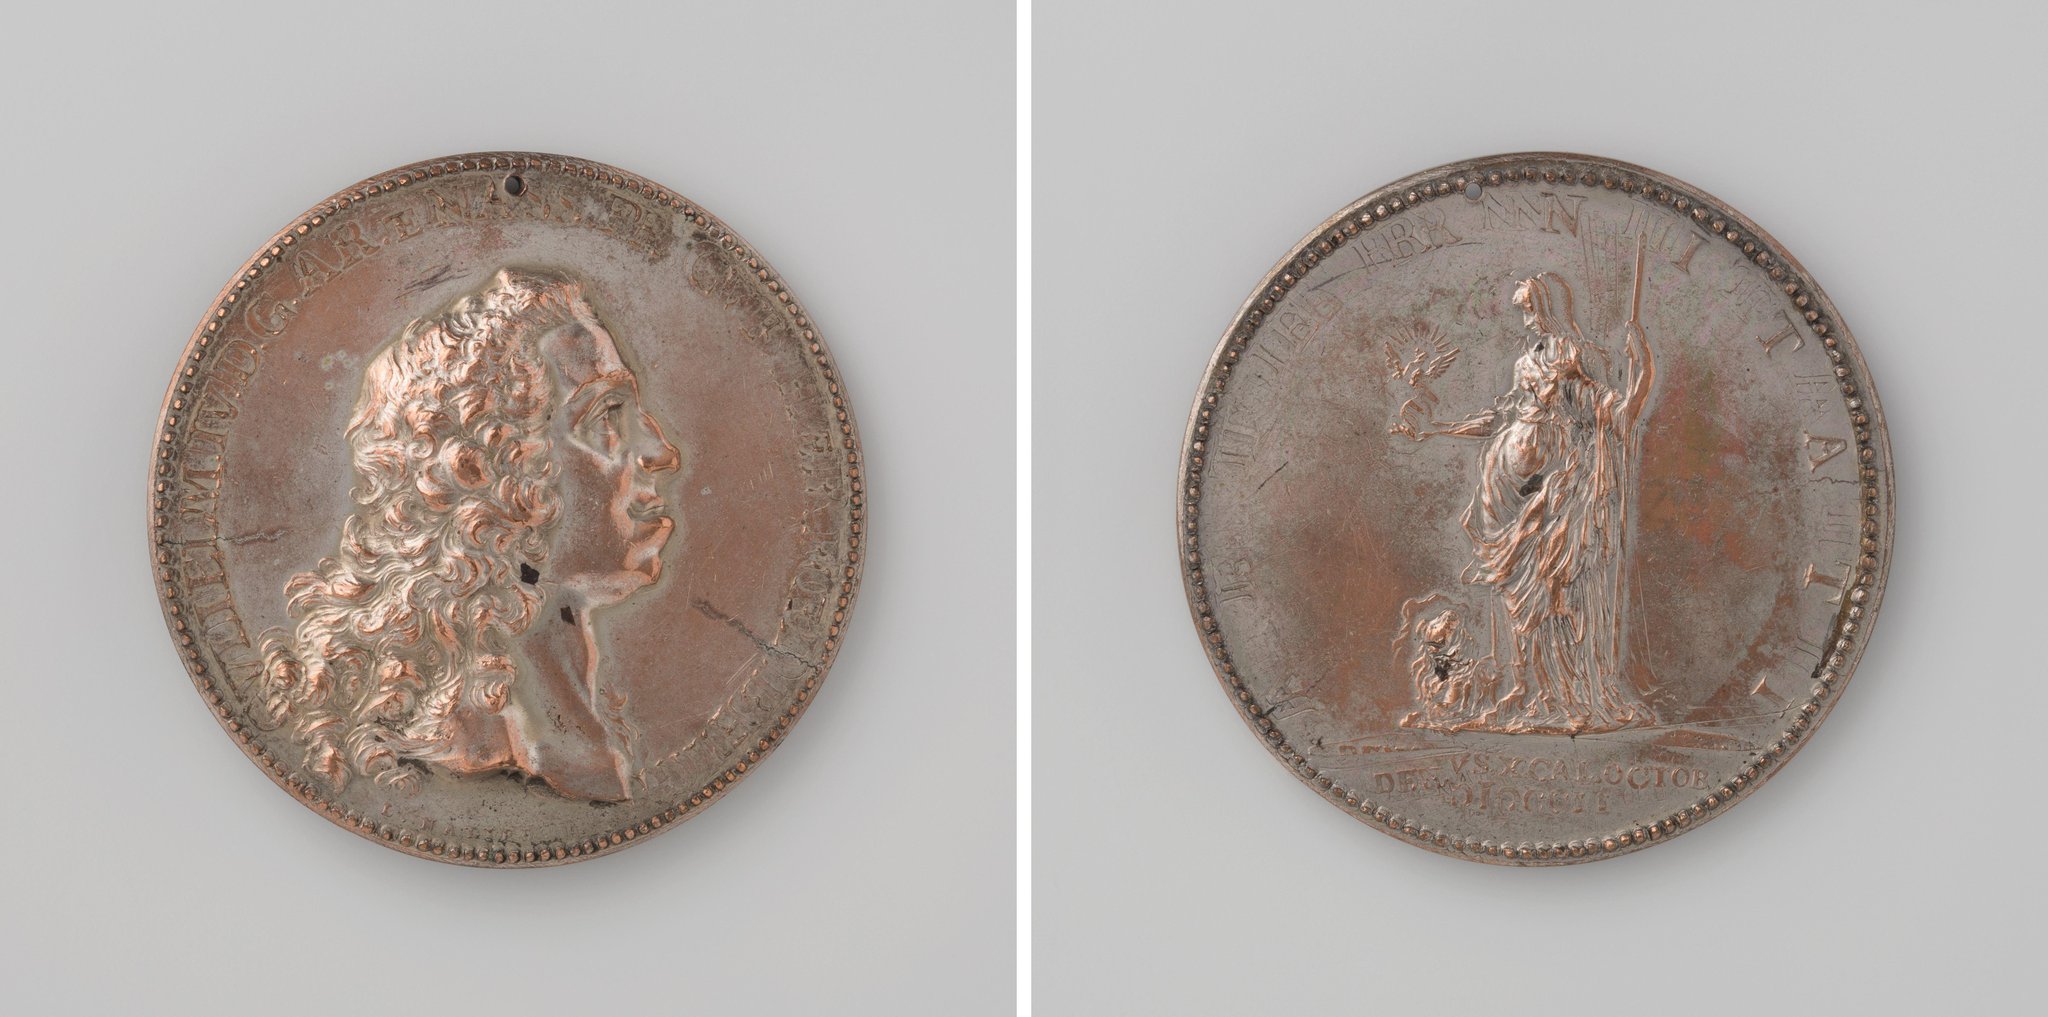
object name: history medal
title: Overlijden van Willem IV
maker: johann lorenz natter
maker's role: medailleur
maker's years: 1705-1763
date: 1751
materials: silver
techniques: striking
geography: amsterdam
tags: the hague, willem iv (prins van oranje-nassau)